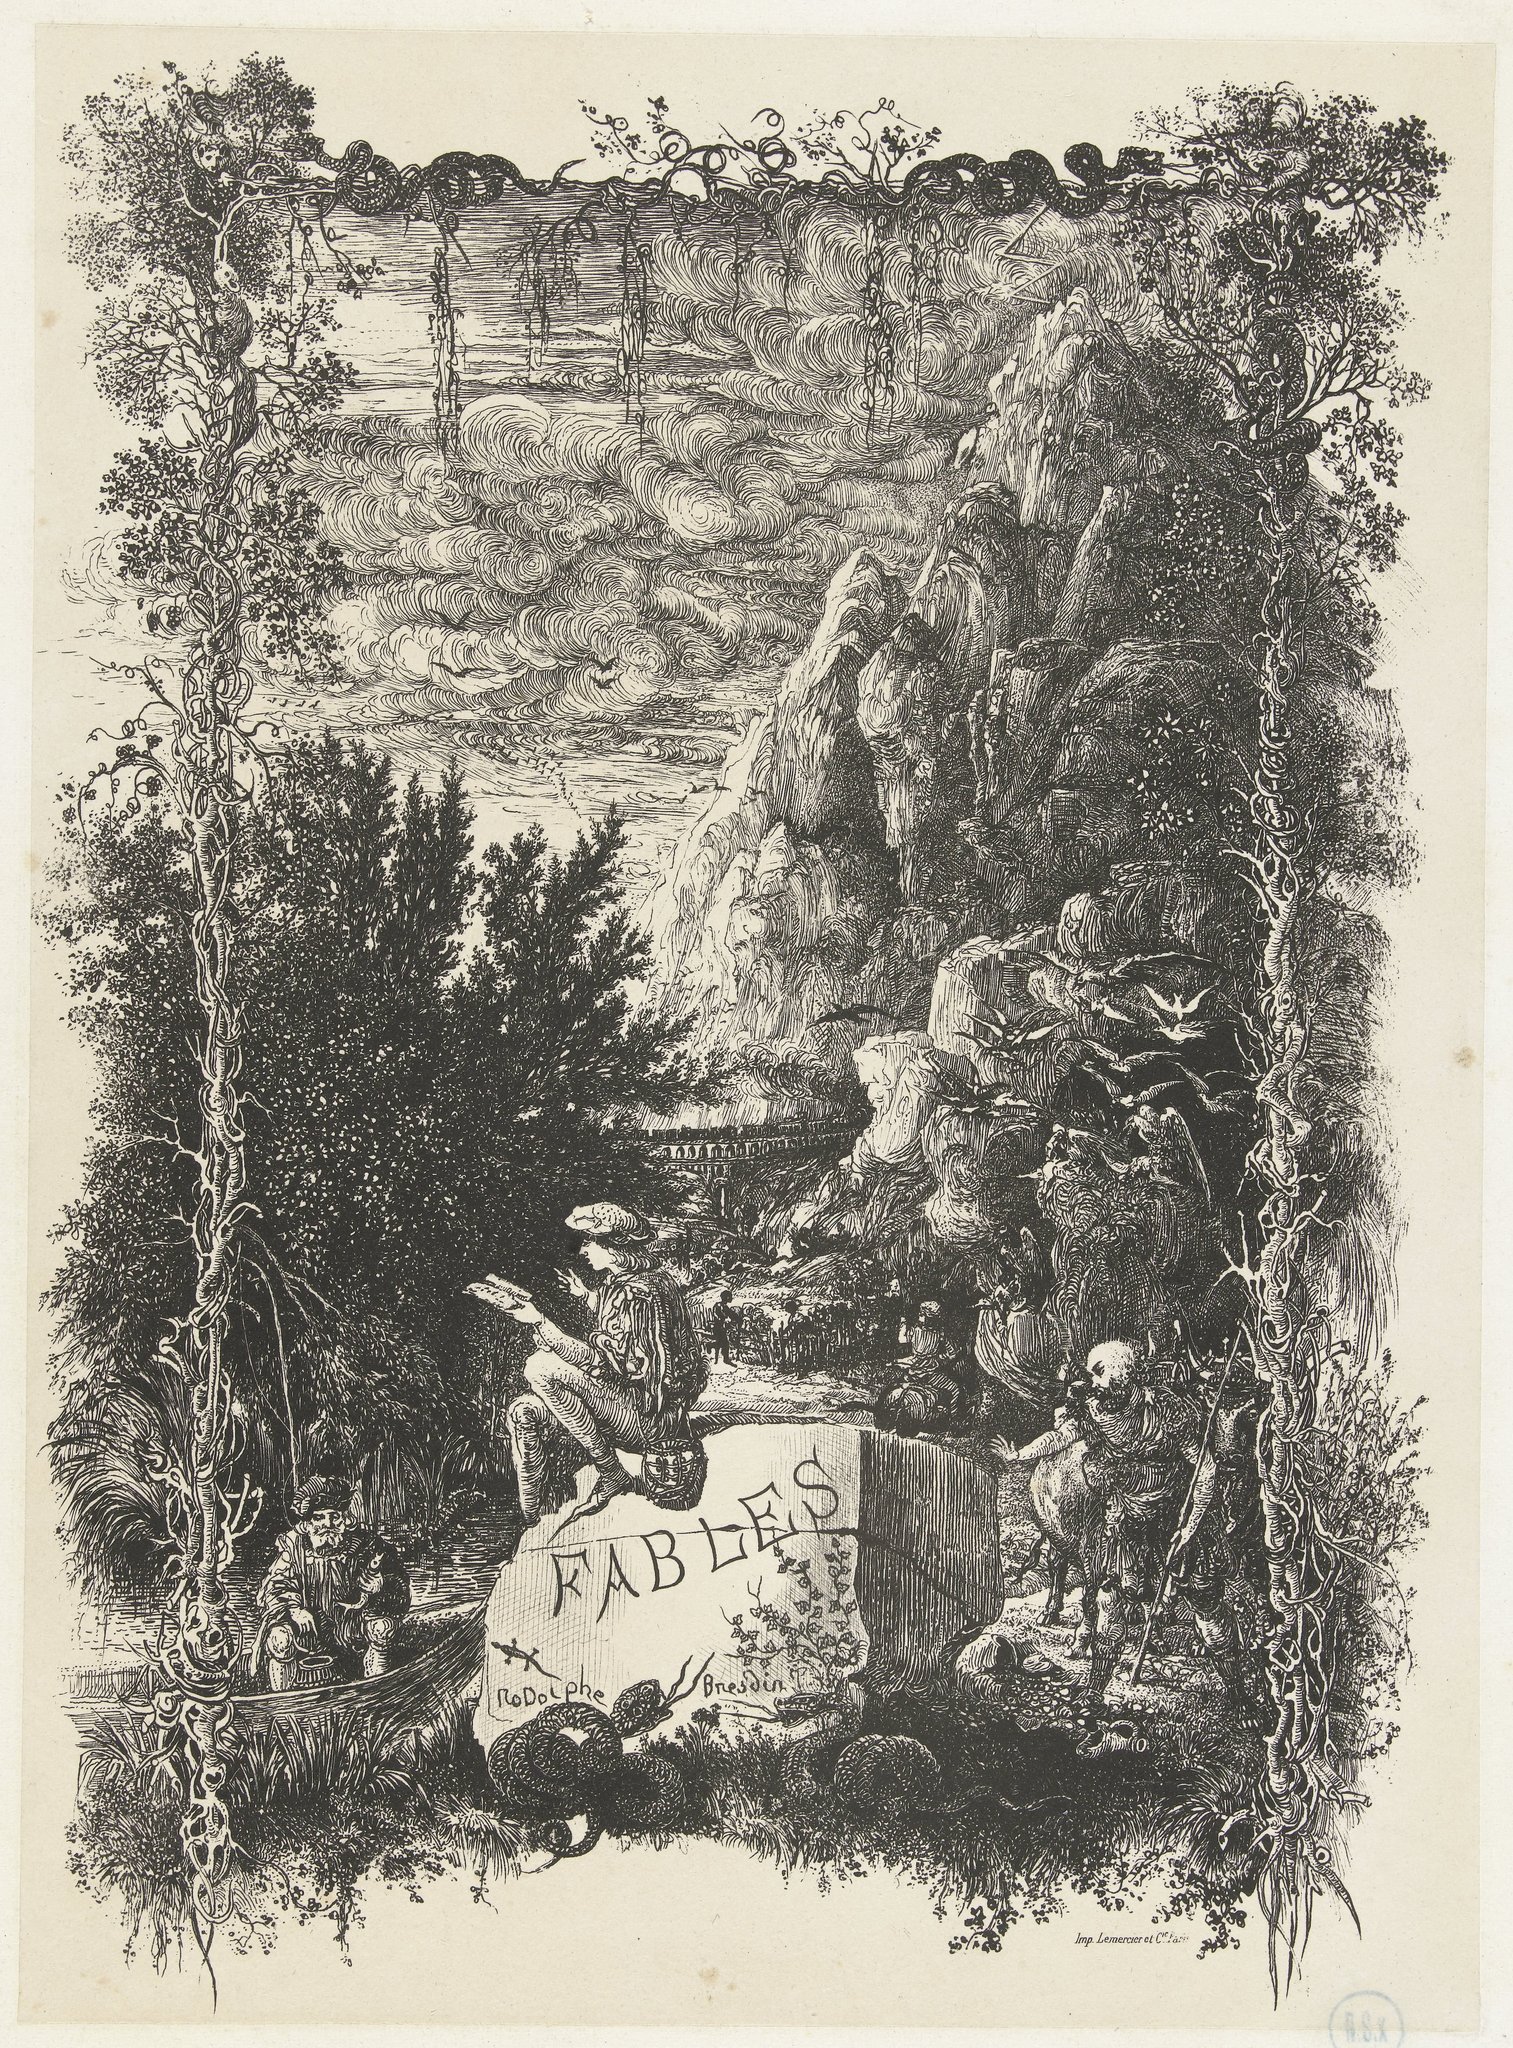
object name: print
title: Frontispice Fables et Contes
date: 1868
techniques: printmaking, lithograph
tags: reading, landscapes in the temperate zone, fables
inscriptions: collector's mark: Lugt 2228, collector's mark: Lugt 2760, collector's mark: Lugt 1989a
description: Titelprent met een landschap waarin verschillende figuren zijn geplaatst die voorkomen in de fabels en verhalen in het boek waarvoor deze illustratie werd ontworpen. Op een grote steen met de tekst Fables zit een jongeman met een boek. Rechts loopt een man met een rund en hij vind een gebroken kruik en de inhoud daarvan. Links zit een man in een bootje te vissen. Vogels of vleermuizen vliegen uit een grot. Op de achtergrond rijst een rots hoog op en een trein verdwijnt in een tunnel. De rechthoekige omlijsting is opgebouwd uit in elkaar gevlochten takken en ranken met hier en daar wat loof. Ook vijf slangen zijn op een vrij natuurlijke manier in het kader opgenomen.